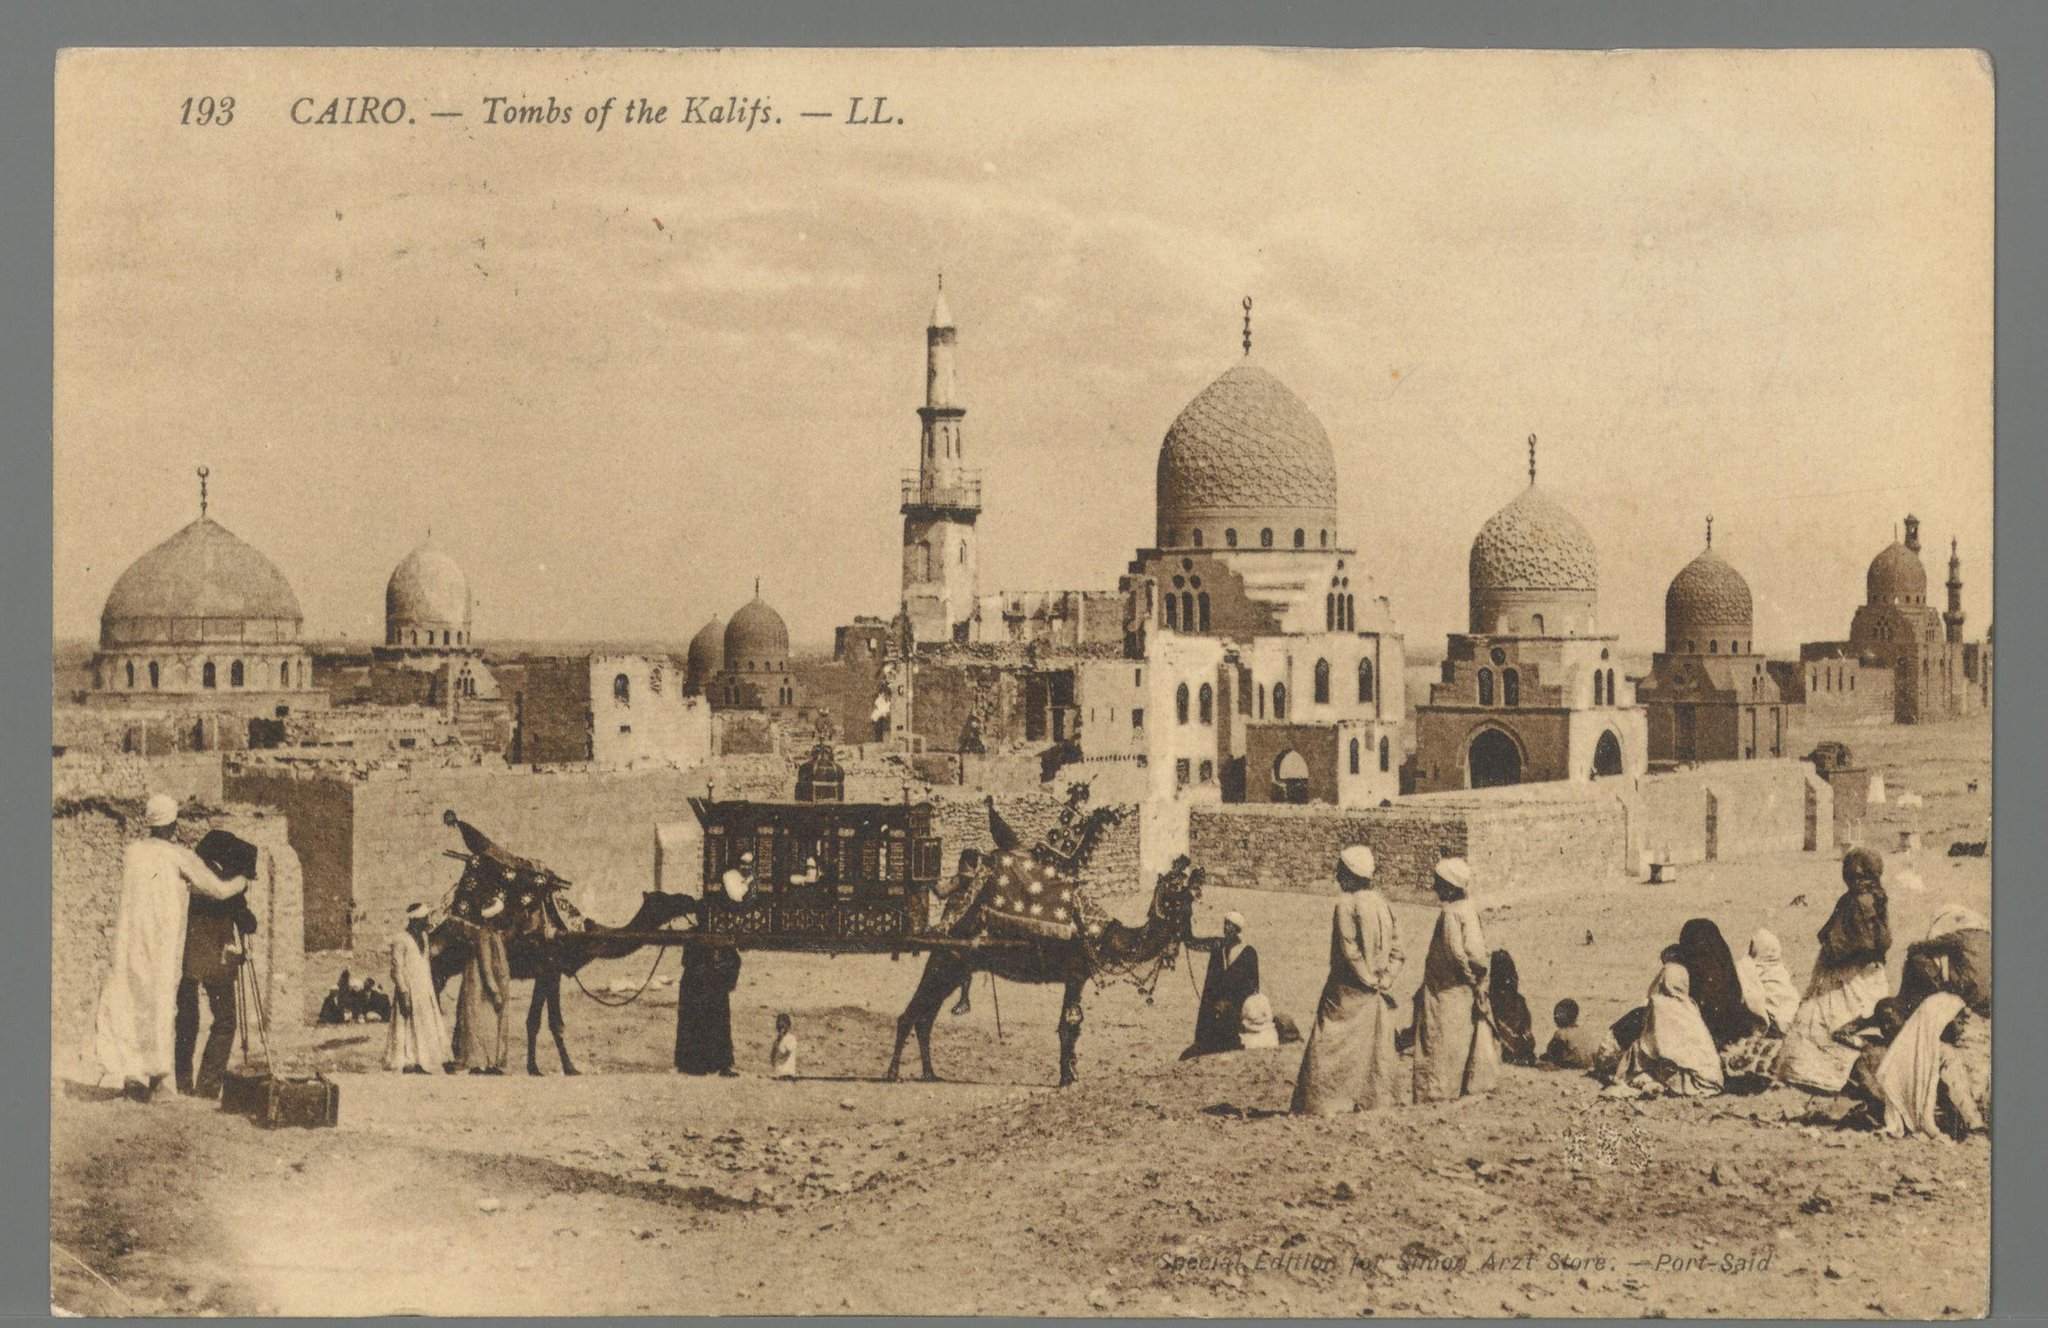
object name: photomechanical print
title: Cairo - Tombs of the Kalifs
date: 1907-1909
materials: cardboard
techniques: photograph, writing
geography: cairo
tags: hearse, funeral car, grave-building, monumental tomb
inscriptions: poststempel, verso, gestempeld